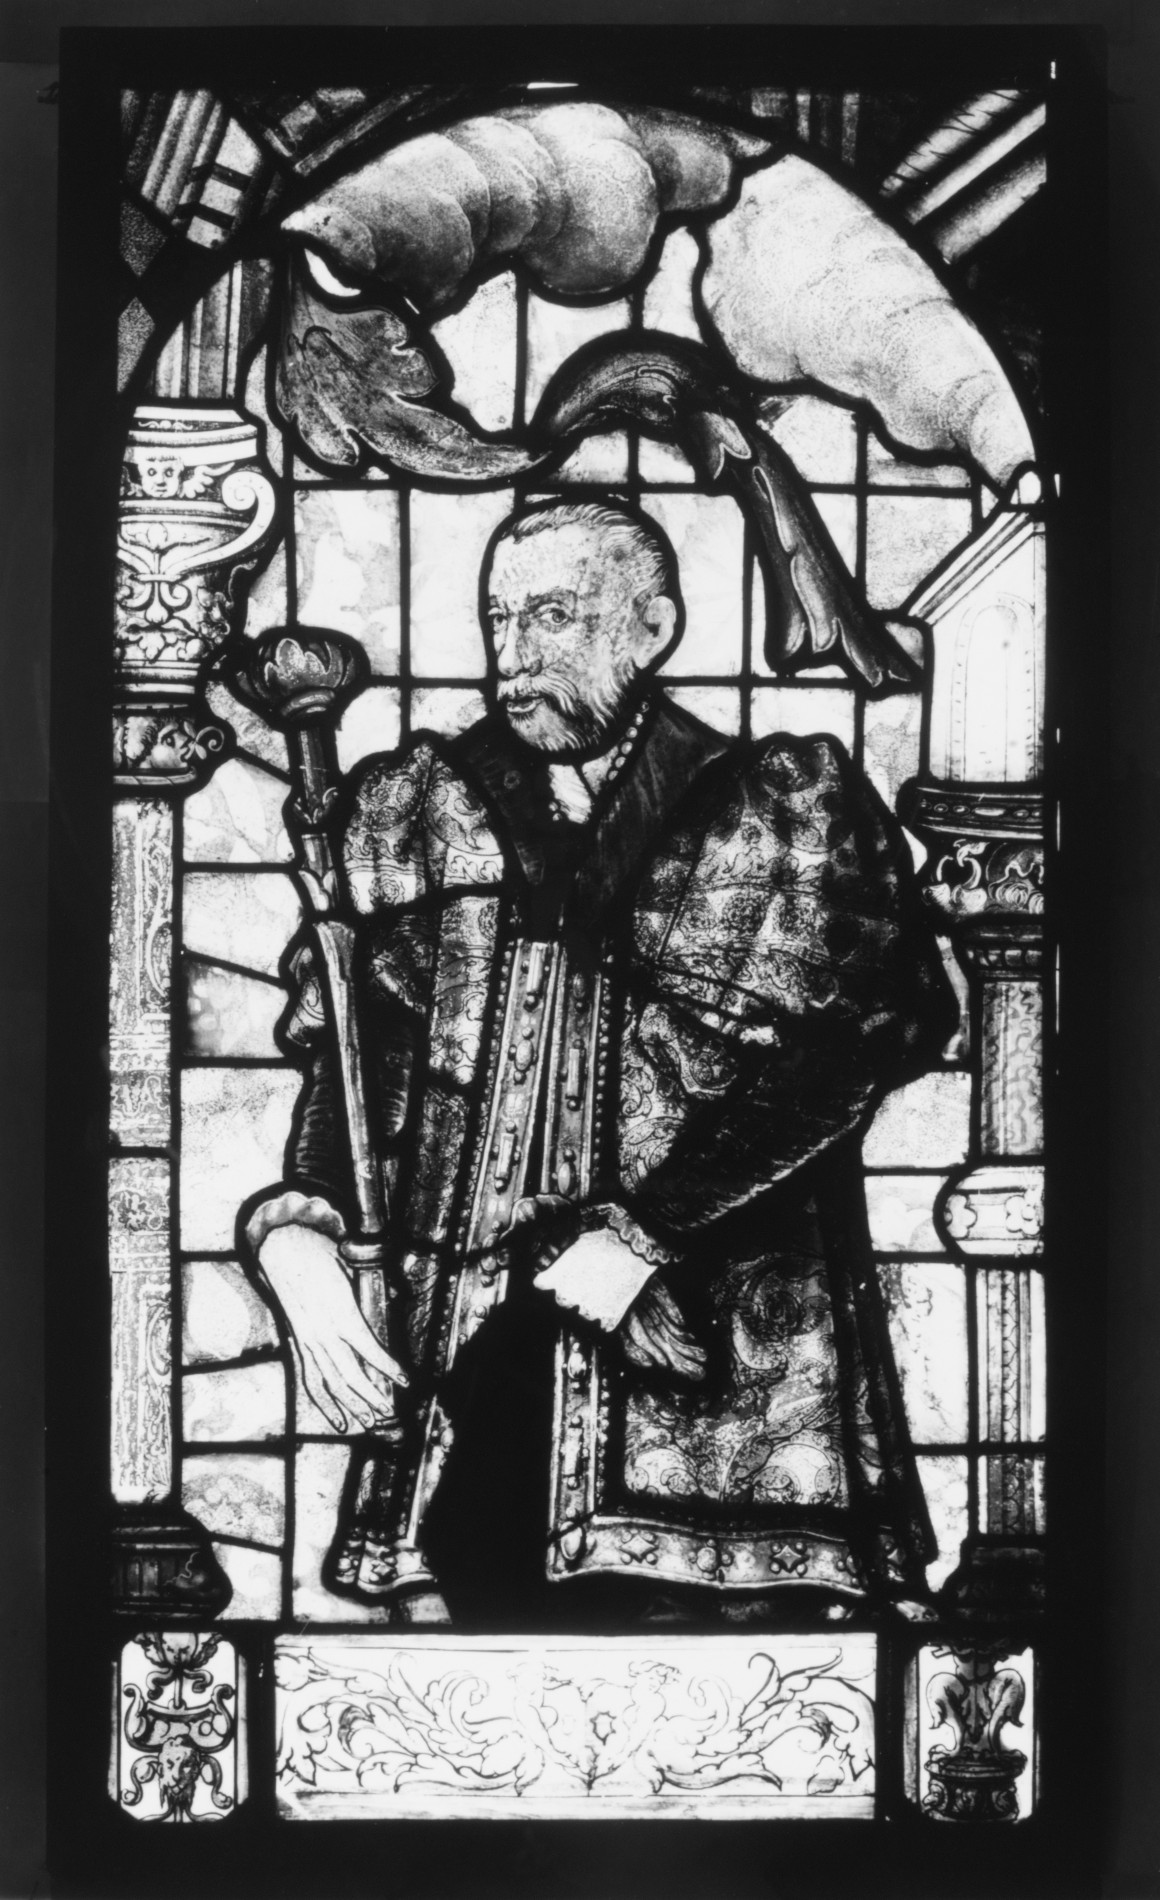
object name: panel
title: Figure of a donor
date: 1550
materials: glass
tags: men